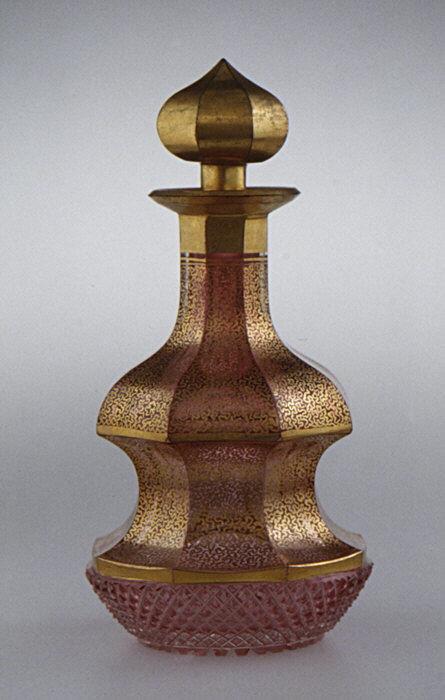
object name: bottle with stopper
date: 1825-1835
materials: gilt, glass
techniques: cutting, polish